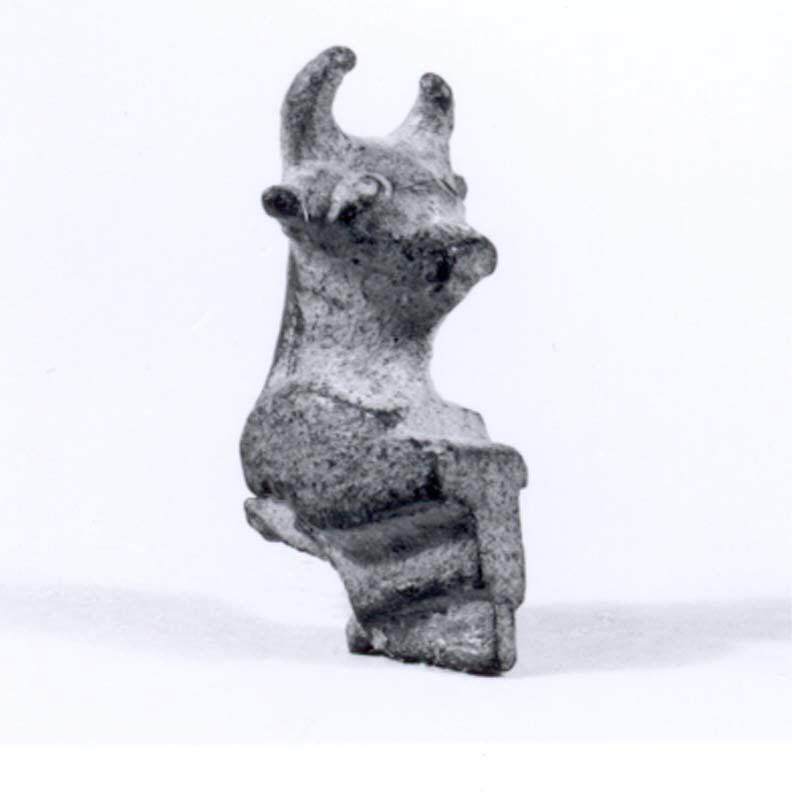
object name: protome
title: Bull's head protome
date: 1000-1 BCE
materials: bronze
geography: transcaucasia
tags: bulls